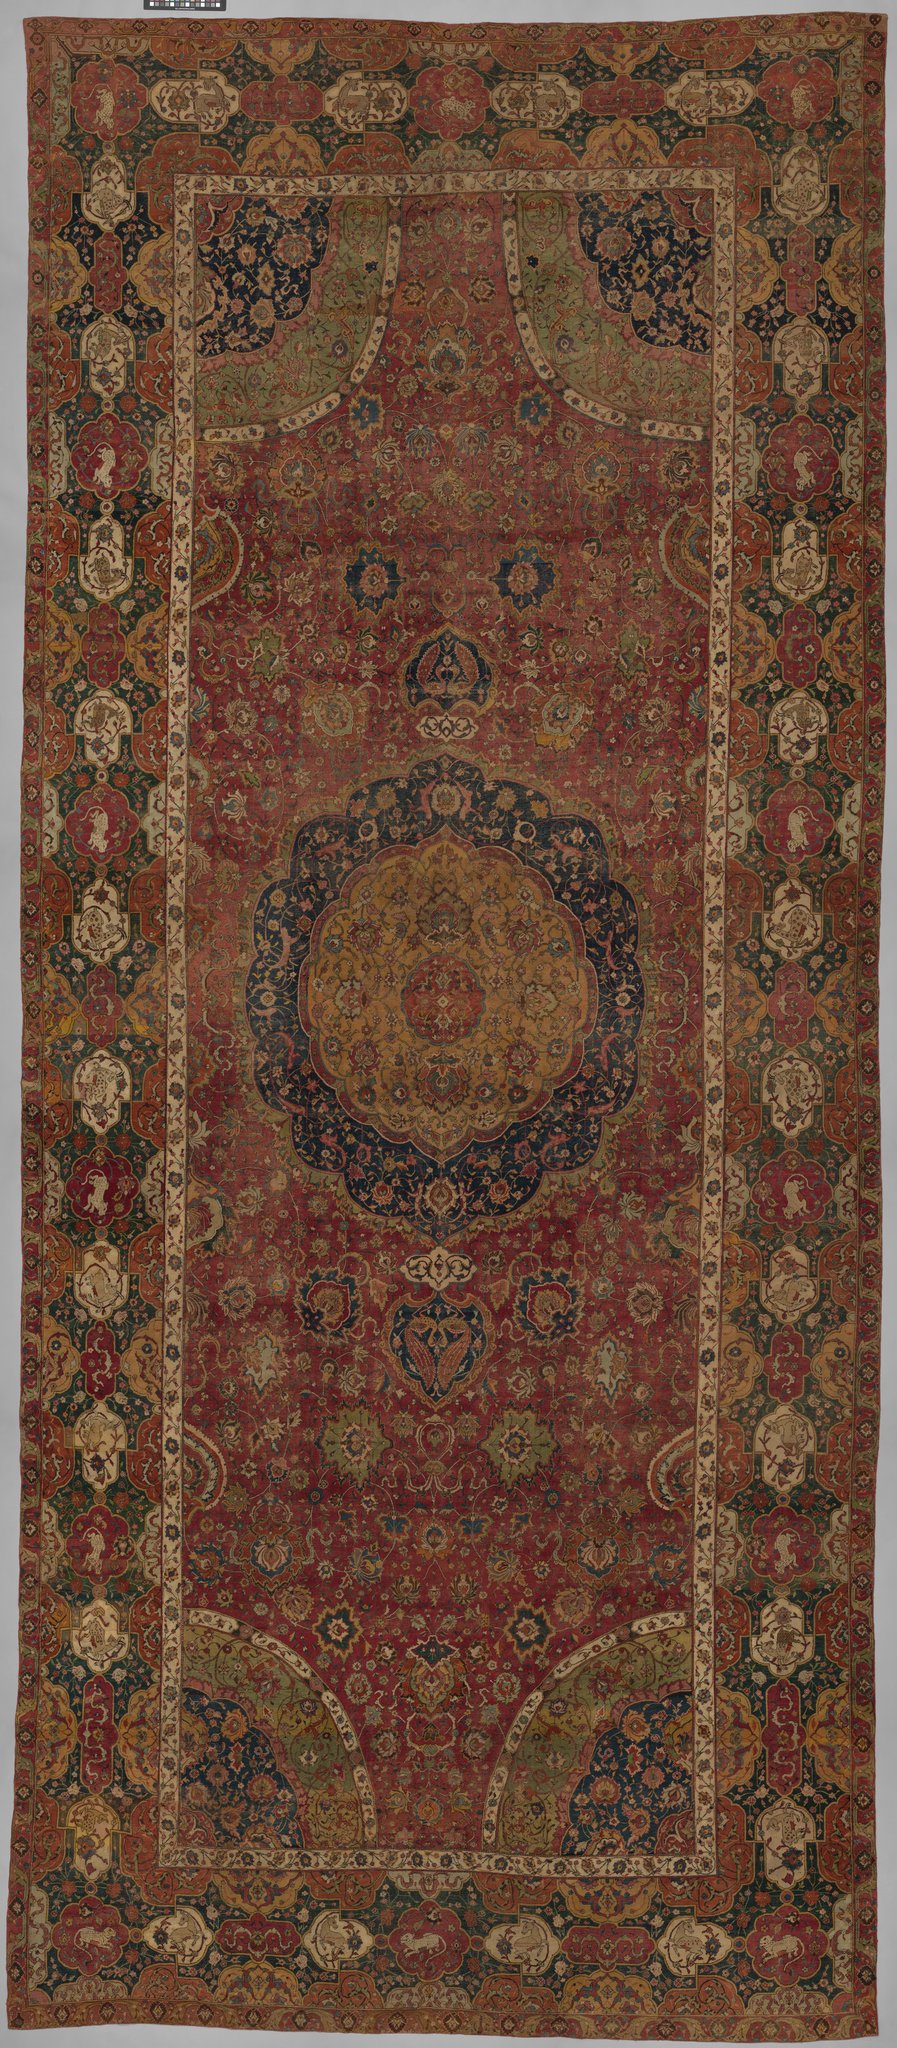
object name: carpet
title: The Seley Carpet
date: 1567-1600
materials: cotton, silk, wool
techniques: asymmetrically knotted pile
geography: iran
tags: animals,deer,flowers